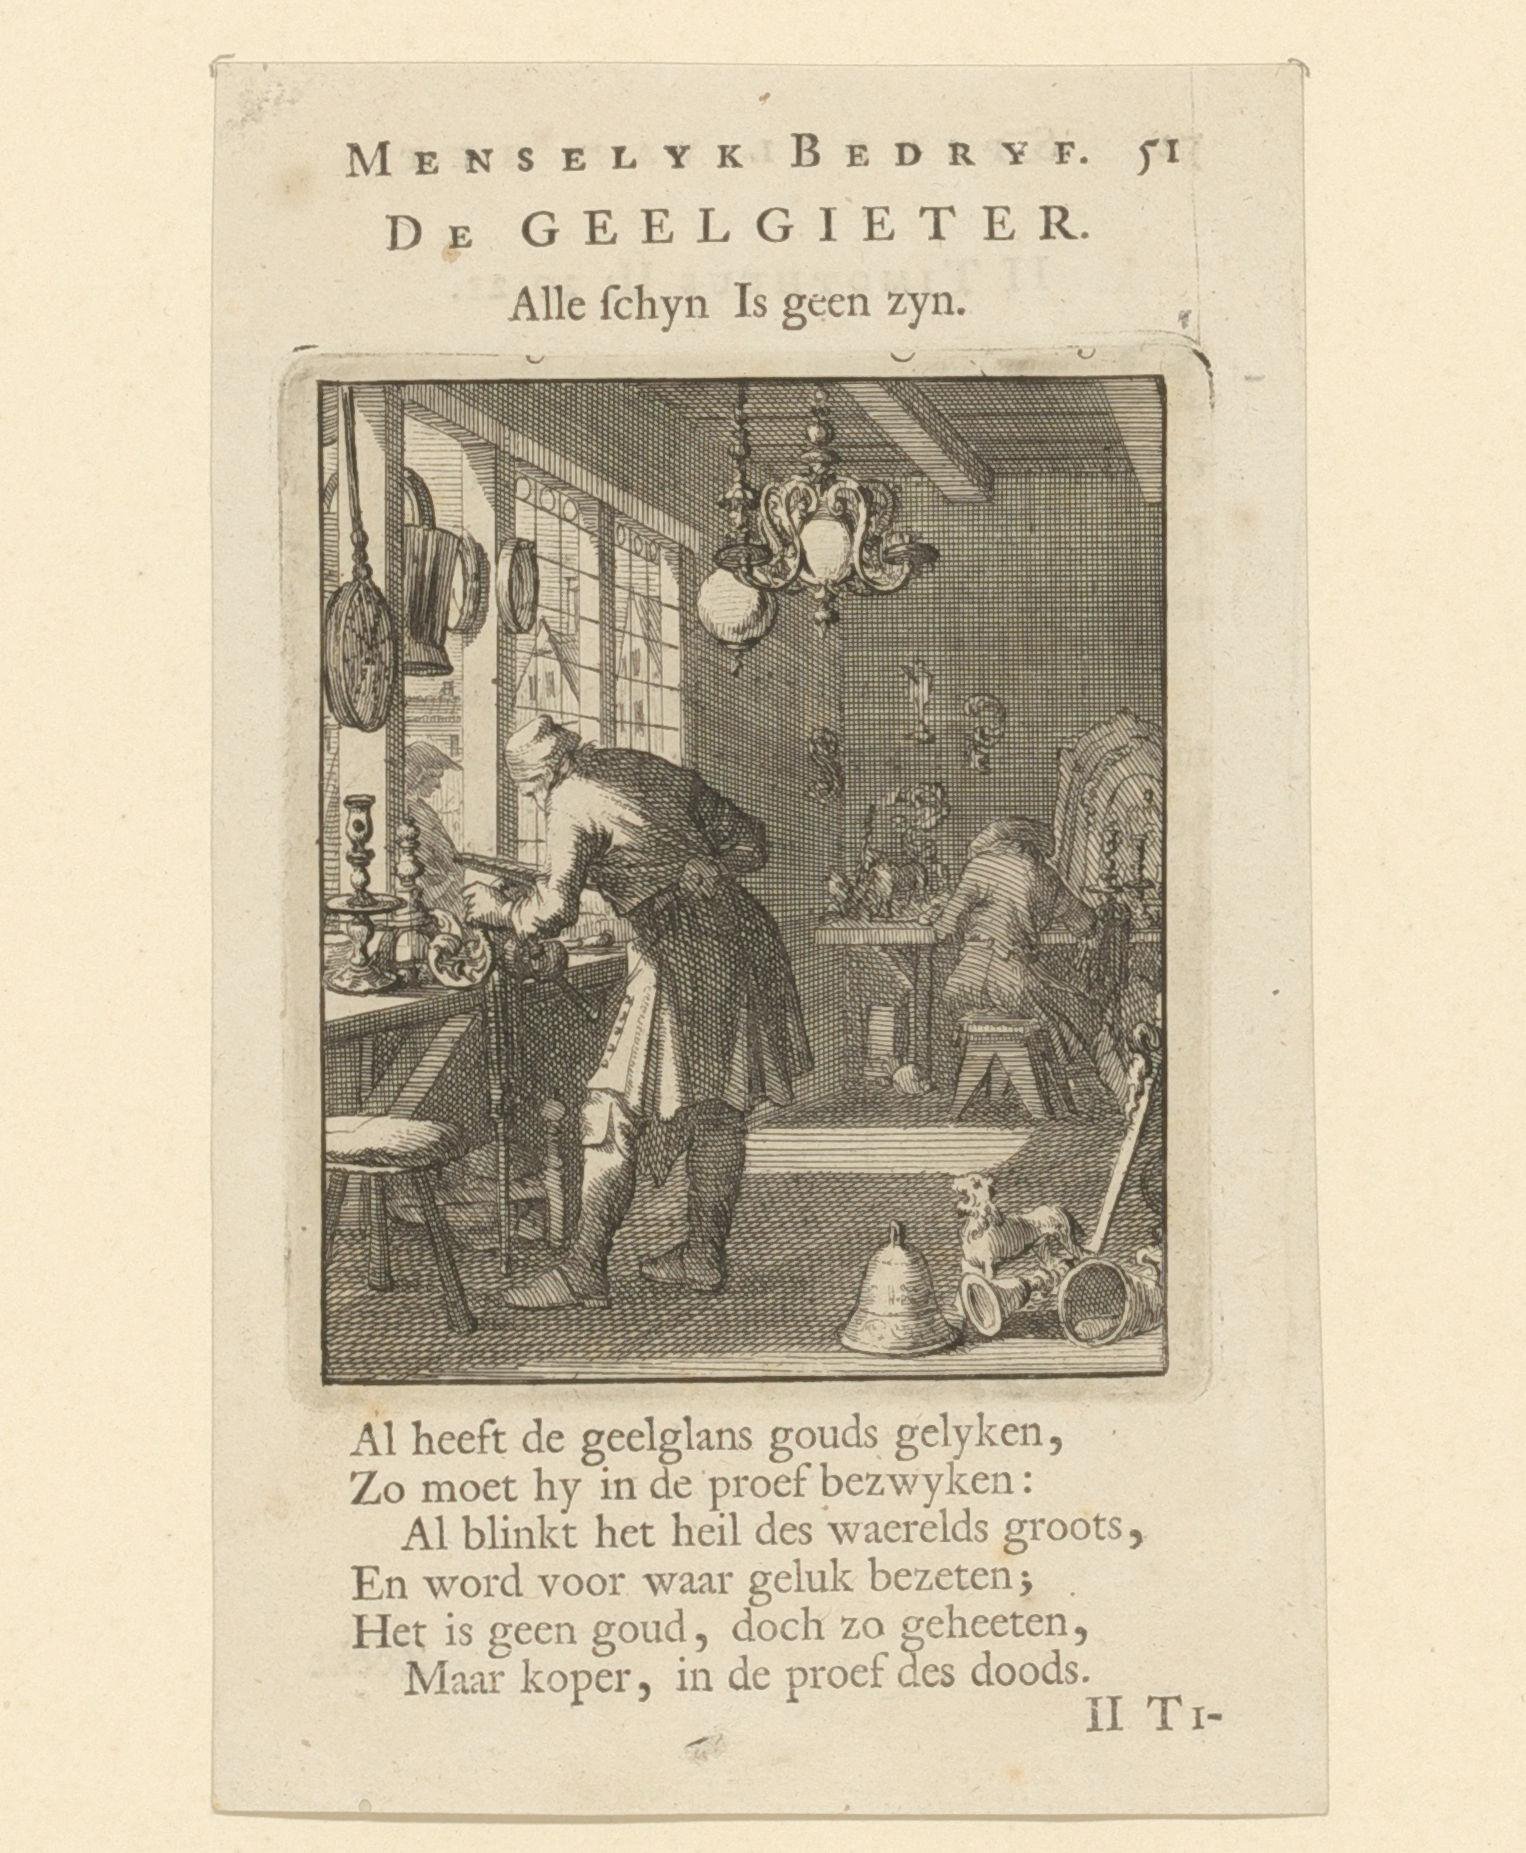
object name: print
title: Geelgieter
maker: cornelis van der sys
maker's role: publisher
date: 1718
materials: paper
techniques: etching, letterpress printing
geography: amsterdam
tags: handicrafts, craftsman at work, handicrafts ~ metal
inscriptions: collector's mark: Lugt 1641, stamp, stamp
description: Prent oorspronkelijk verschenen in de 100-delige serie beroepsprenten van Jan en Caspar Luyken, getiteld: Het menselyk bedryf. S.l.s.n., 1694 (eerste druk). Daarna is de titel en het vers afgesneden. De prenten in diverse publicaties verschenen en gekopieerd. Huidige staat uit: Luyken, Jan en Caspar. Spiegel van het menselyk bedryf (...). Amsterdam: Cornelis van der Sys, 1718, p. 51. Prent waarschijnlijk ook gebruikt in eerdere (1704) en latere (1730, 1749, 1767) publicaties.